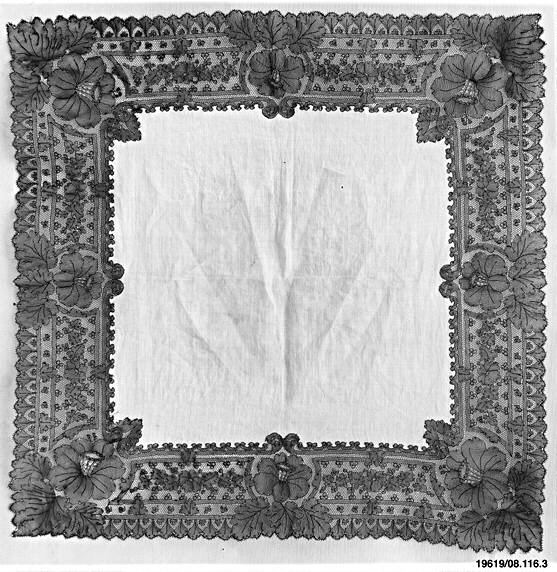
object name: handkerchief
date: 1801-1900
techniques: lace